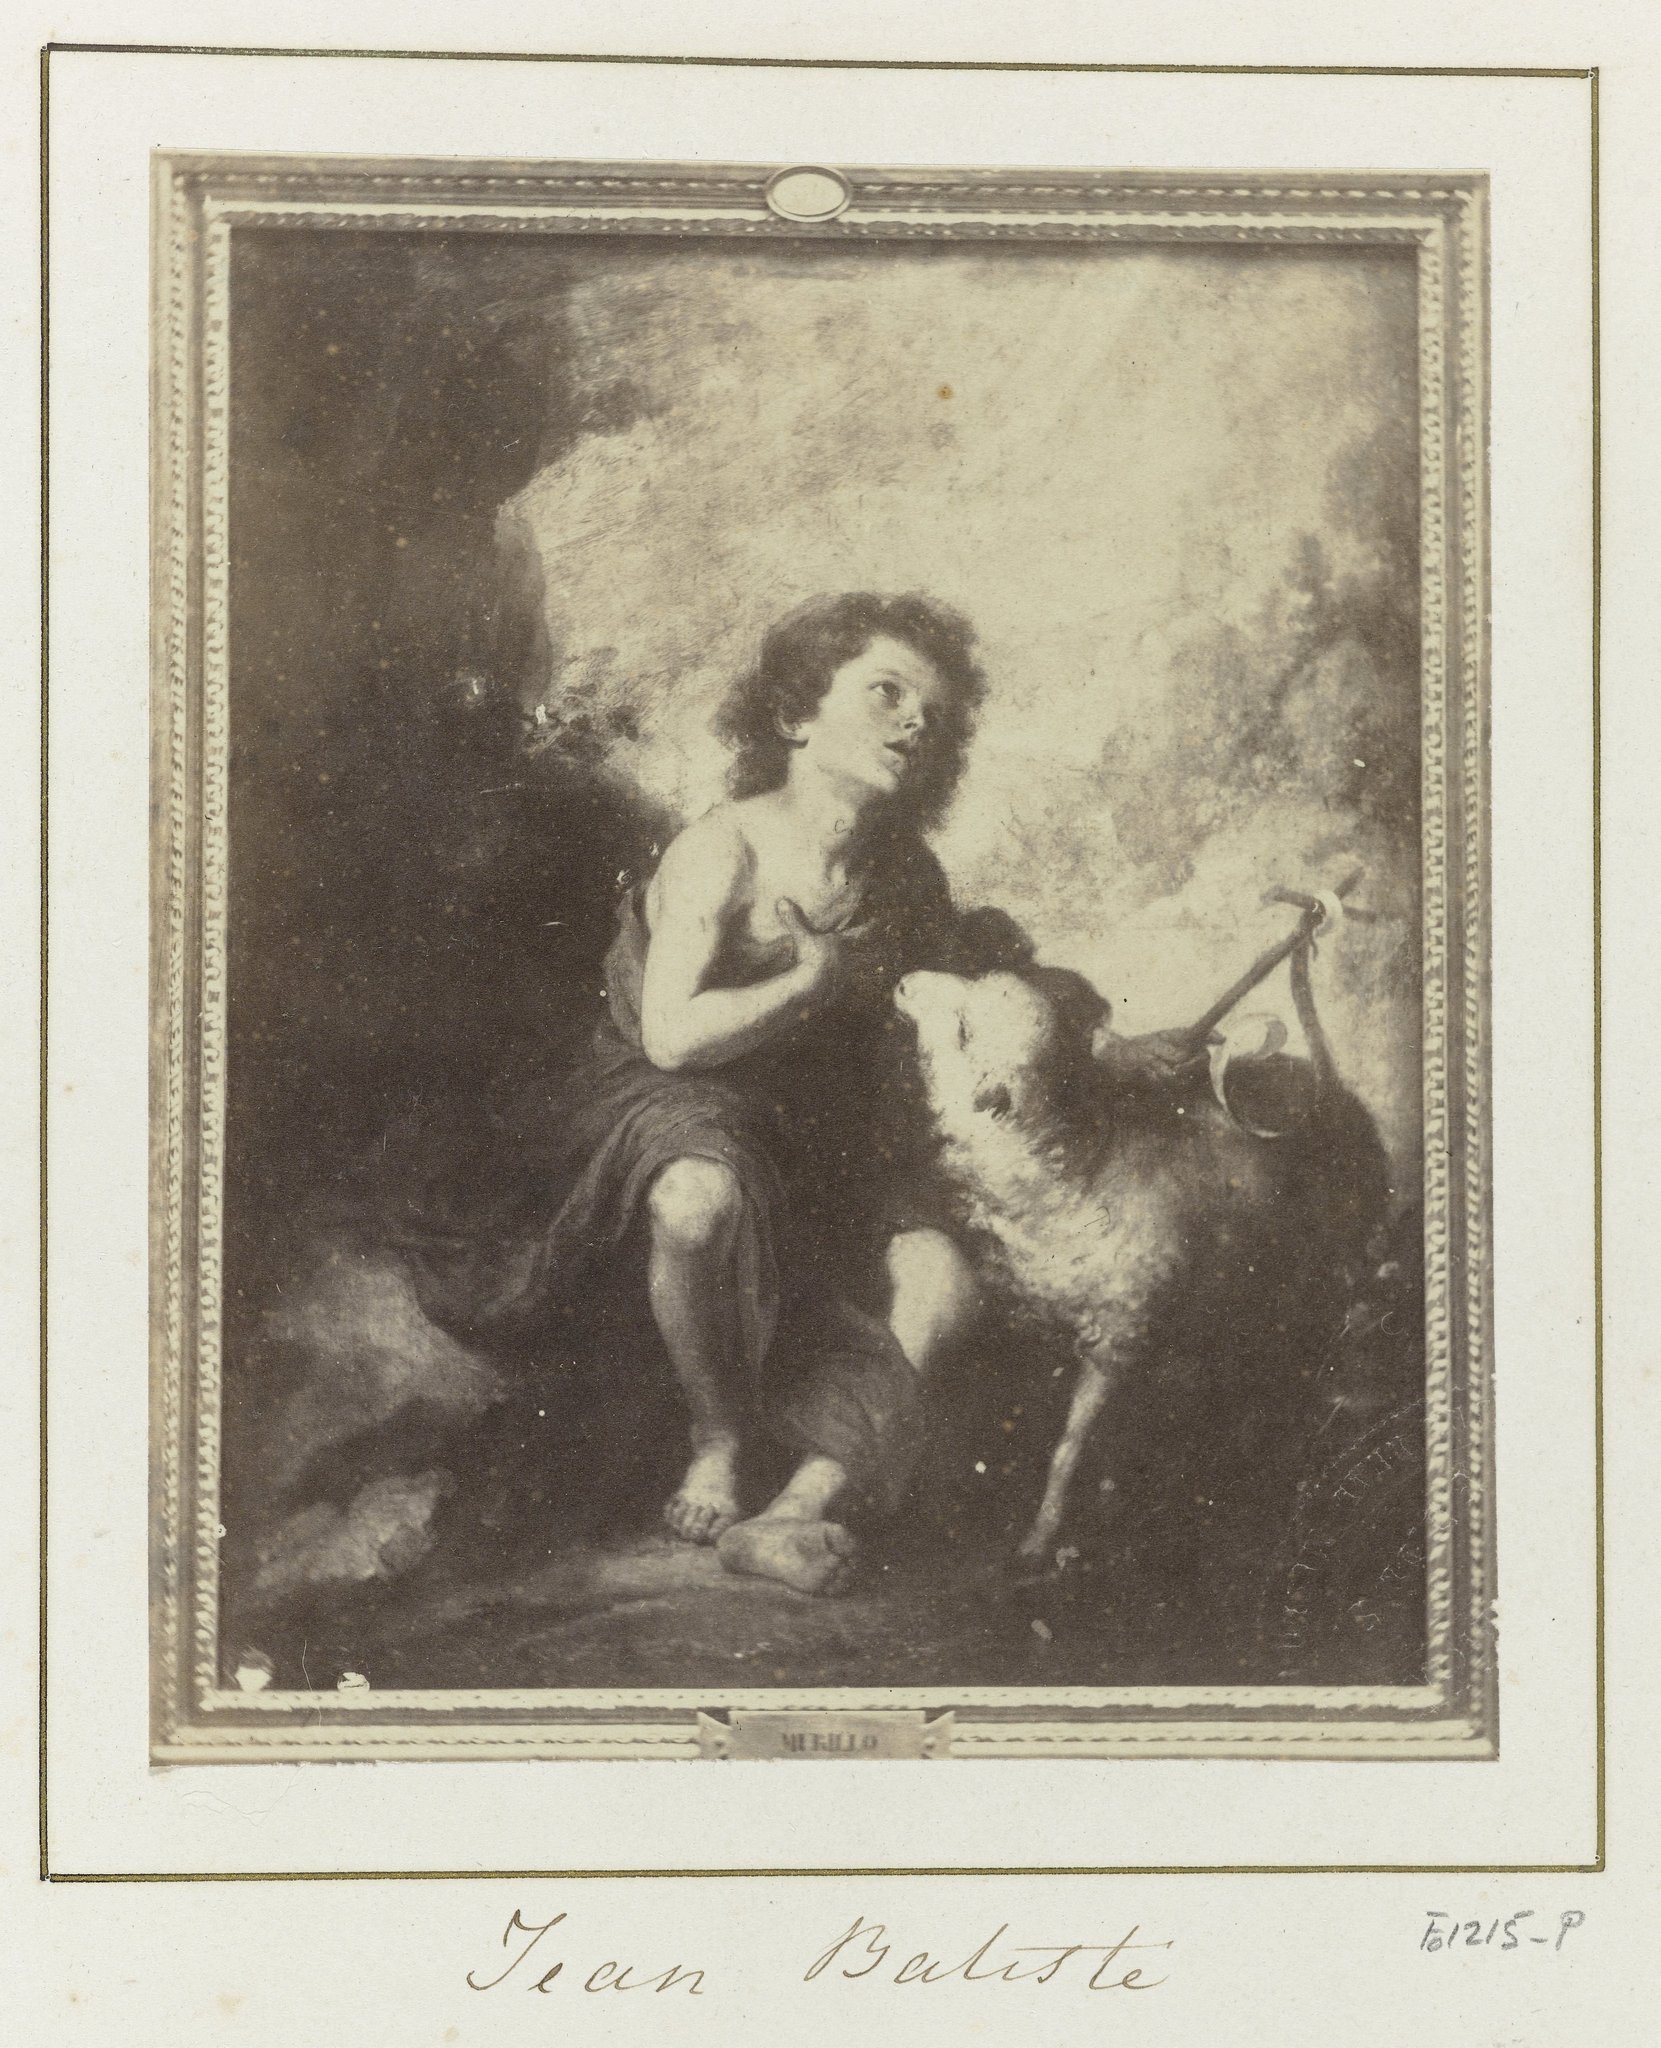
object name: photograph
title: Fotoreproductie van een schilderij door Bartolomé Esteban Murillo, voorstellend Johannes de Doper als kind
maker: Anonymous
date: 1860-1875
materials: photographic support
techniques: albumen print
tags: child, lamb, series of scenes from the life of john the baptist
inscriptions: inscription: ‘[...]de S. [...]’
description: Onderdeel van Reisalbum met opnames van kunstwerken, personen en bezienswaardigheden in Spanje.